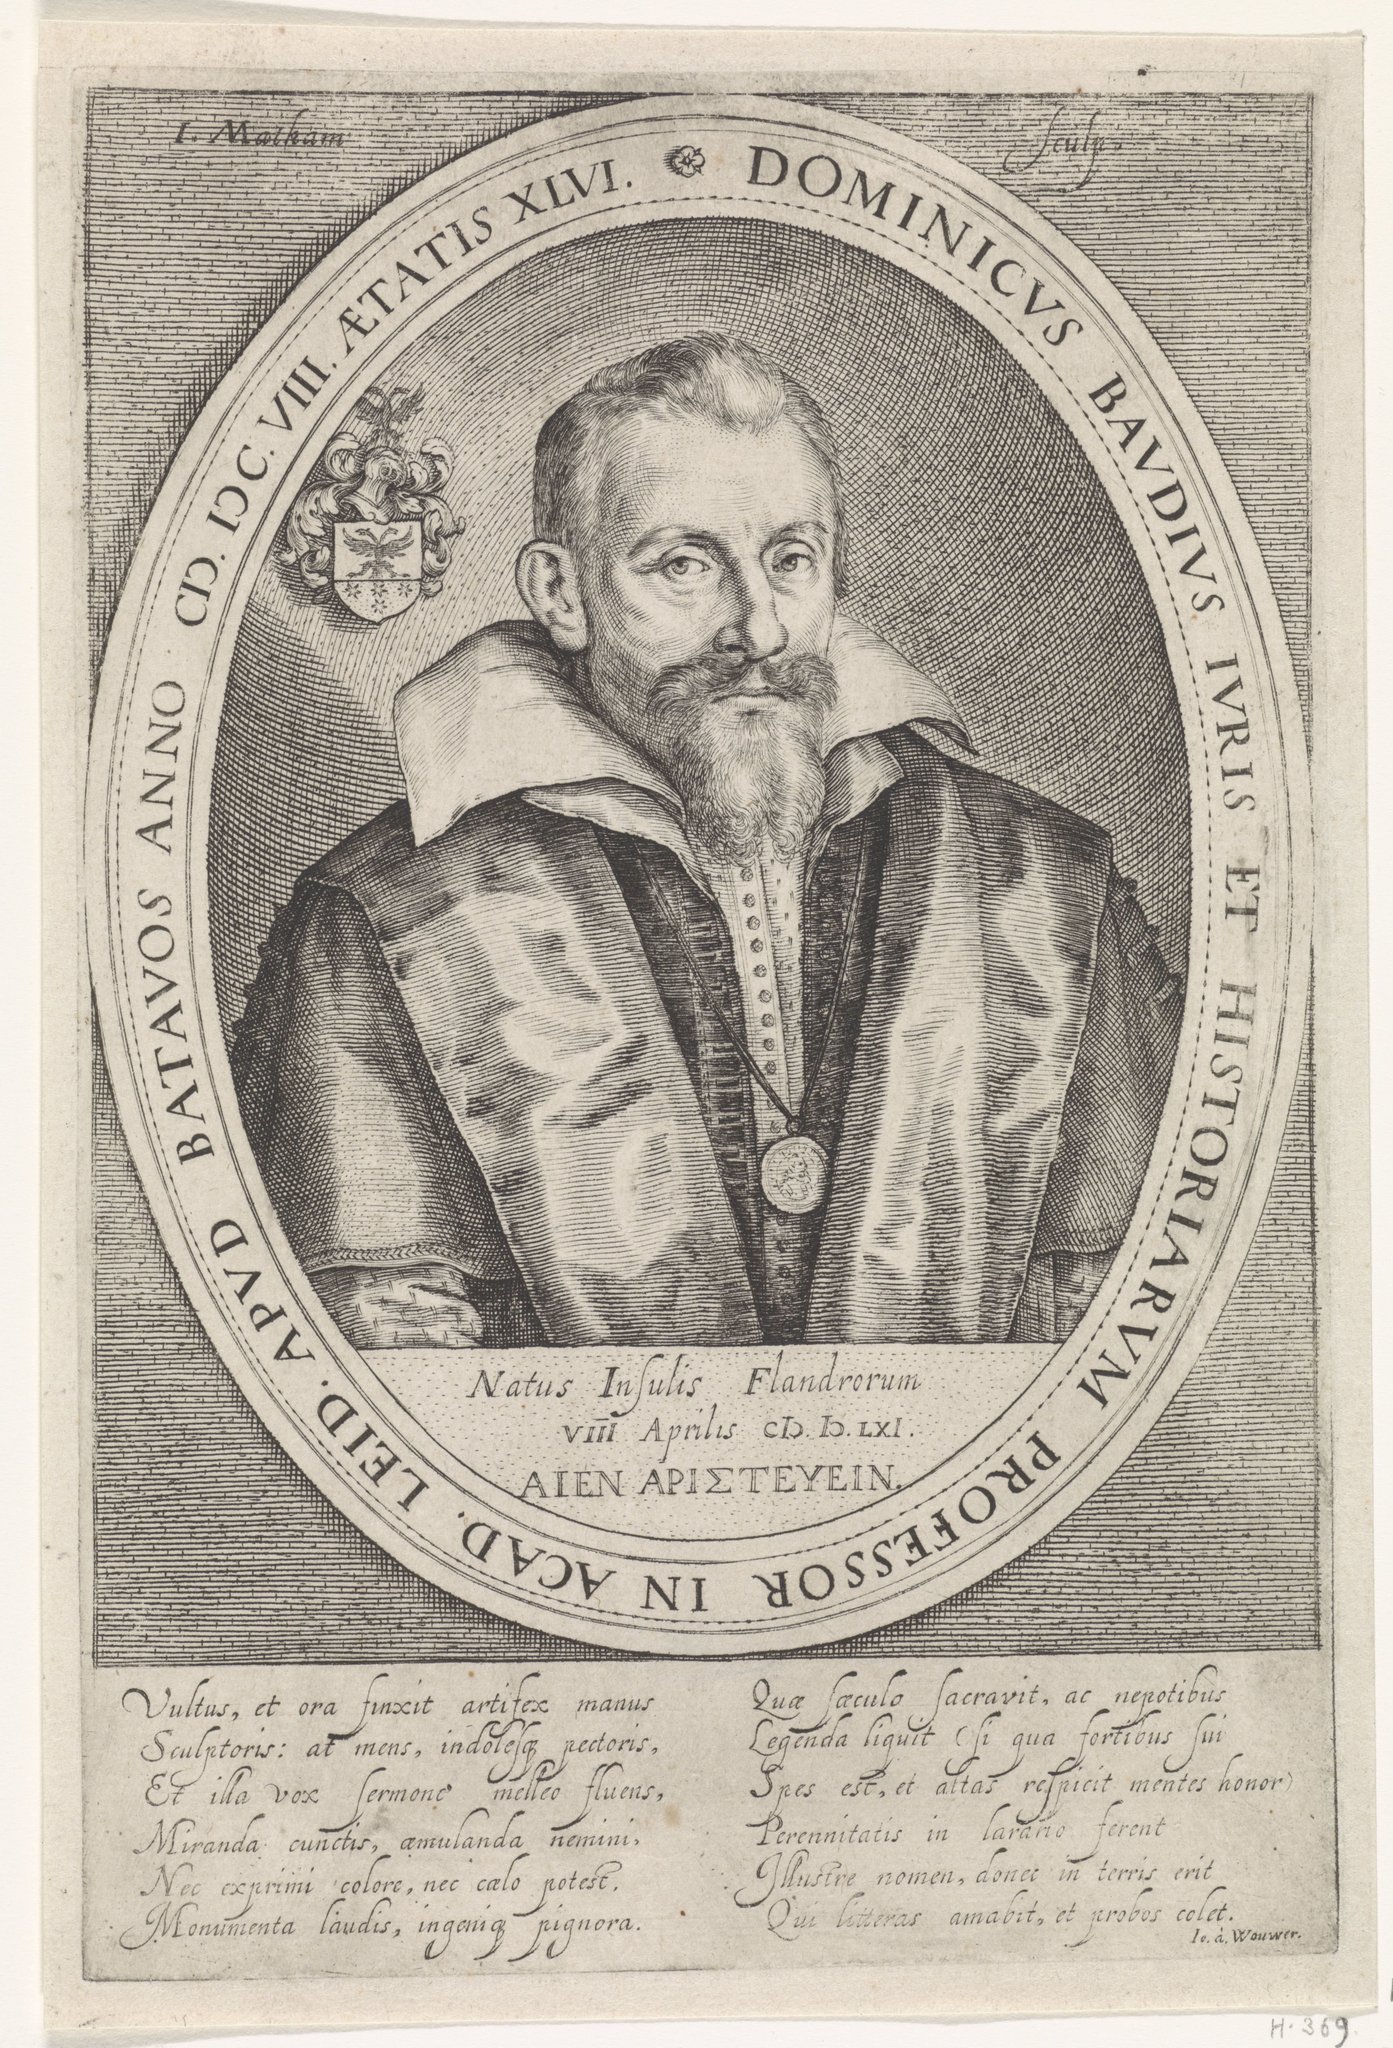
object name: print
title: Portret van Dominicus Baudius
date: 1608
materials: paper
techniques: engraving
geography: haarlem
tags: lille, leiden, dominicus baudius, historical persons, portrait of a writer, professor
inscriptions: collector's mark: Lugt 2228, signature: ‘I.Matham sculp’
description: Portret van Dominicus Baudius, dichter en professor te Leiden, op 46-jarige leeftijd.